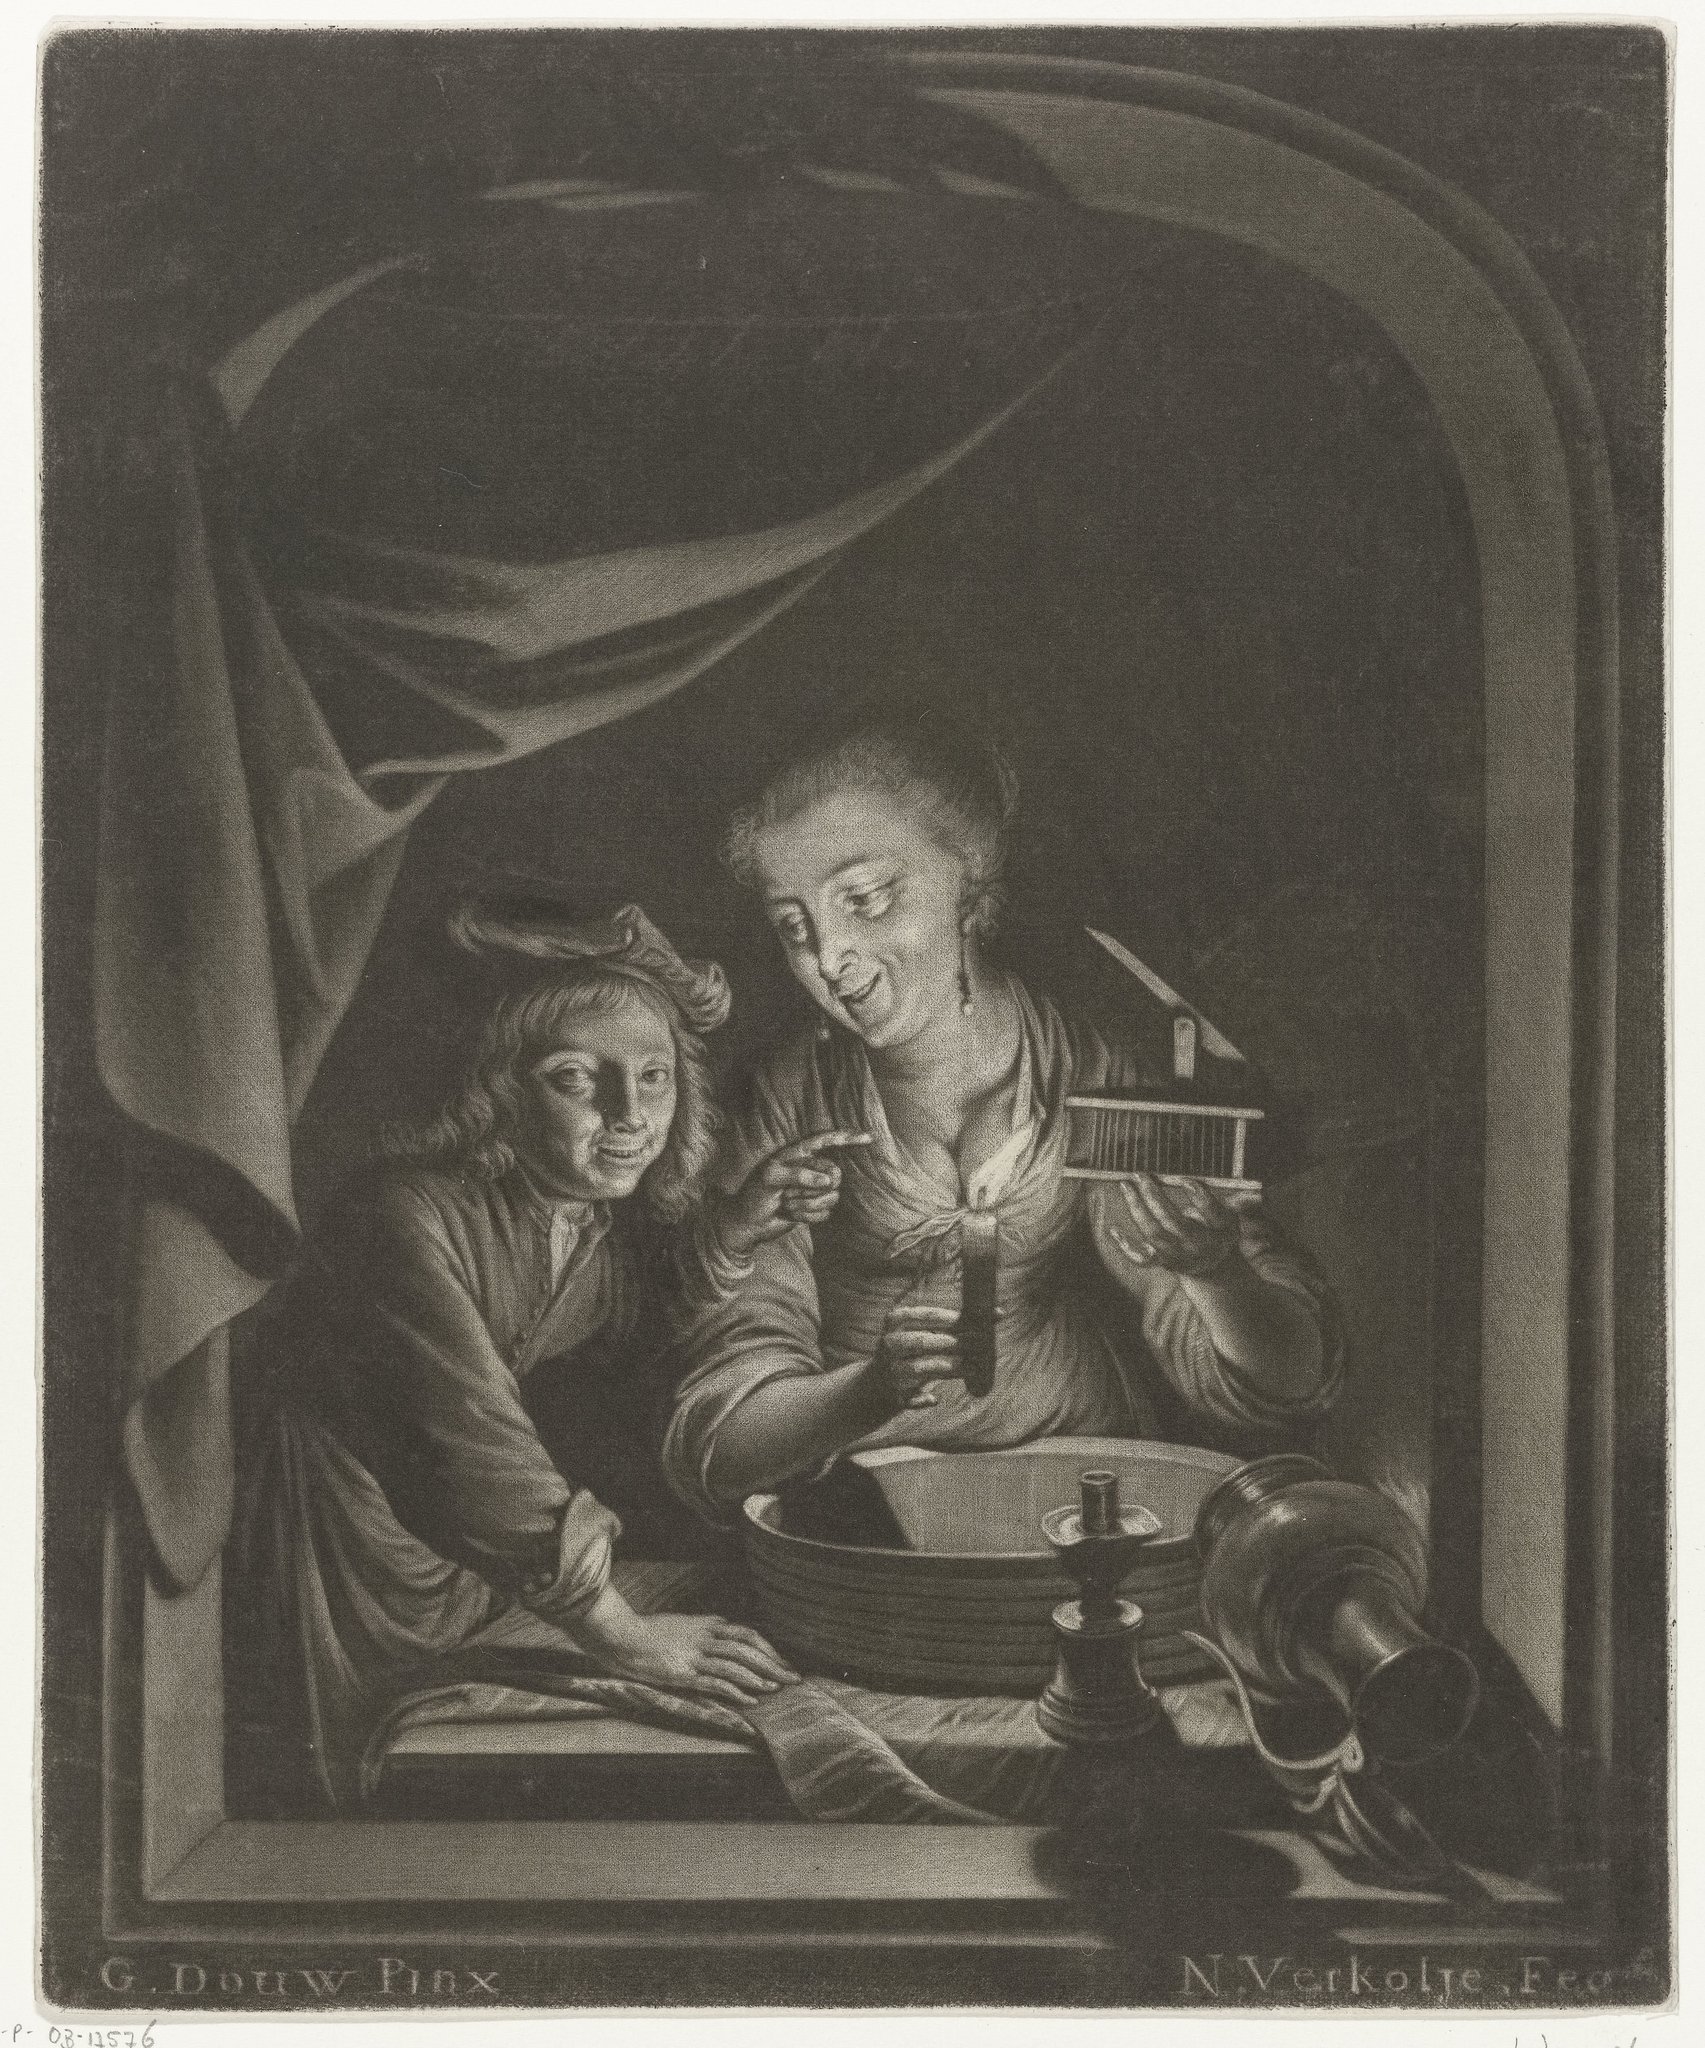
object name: print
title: Muizenval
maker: gerard dou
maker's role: draughtsman, painter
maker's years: 1613-1675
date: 1683-1746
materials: paper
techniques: mezzotint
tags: human figure at (open) window, seen from outside - aa - feigned window, mouse trap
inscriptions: collector's mark: Lugt 240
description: In een vensteropening laat een vrouw, bij kaarslicht, een muizenval aan een jongen zien. De jongen wijst op de val.